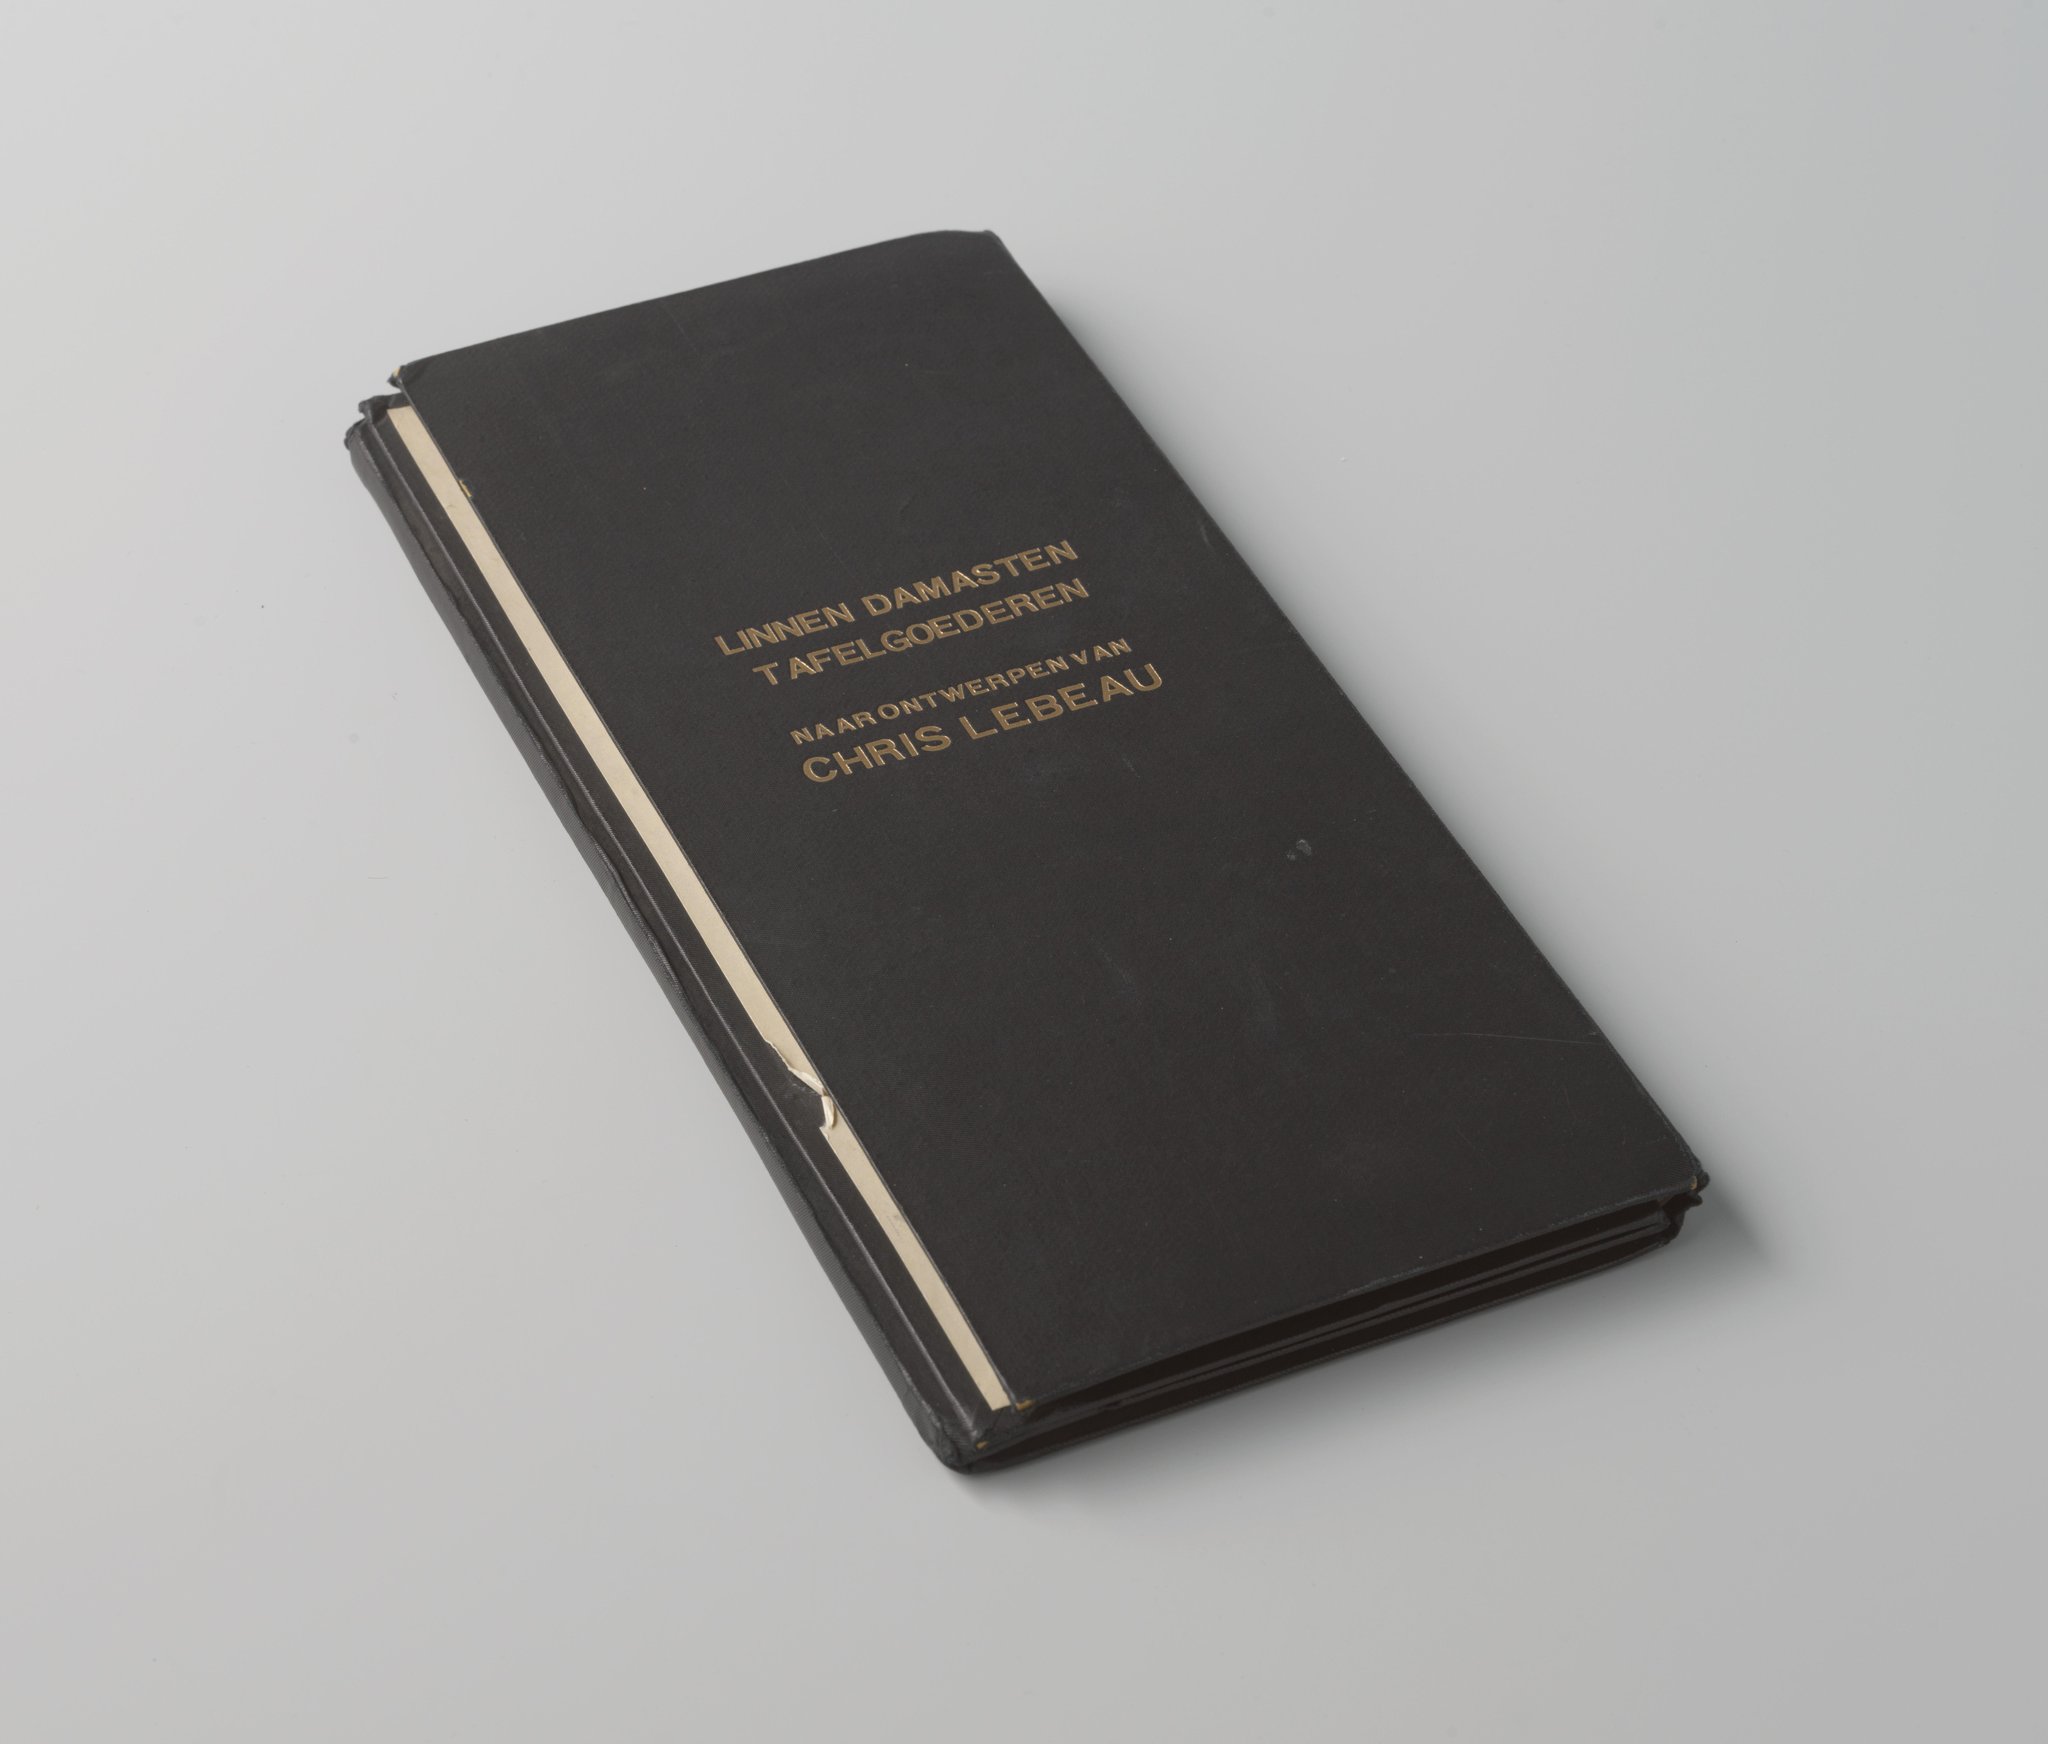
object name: pattern book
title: Stalenboek met damaststalen en foto's, ontwerpen Cornelis van der Sluys en Chris Lebeau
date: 1900-1945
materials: cardboard, linen, paper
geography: eindhoven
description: Stalenboek met zestien damaststalen en foto's naar ontwerp van Cornelis van der Sluys en Chris Lebeau, dessins 500 etc. E.J.F. van Dissel & Zonen.